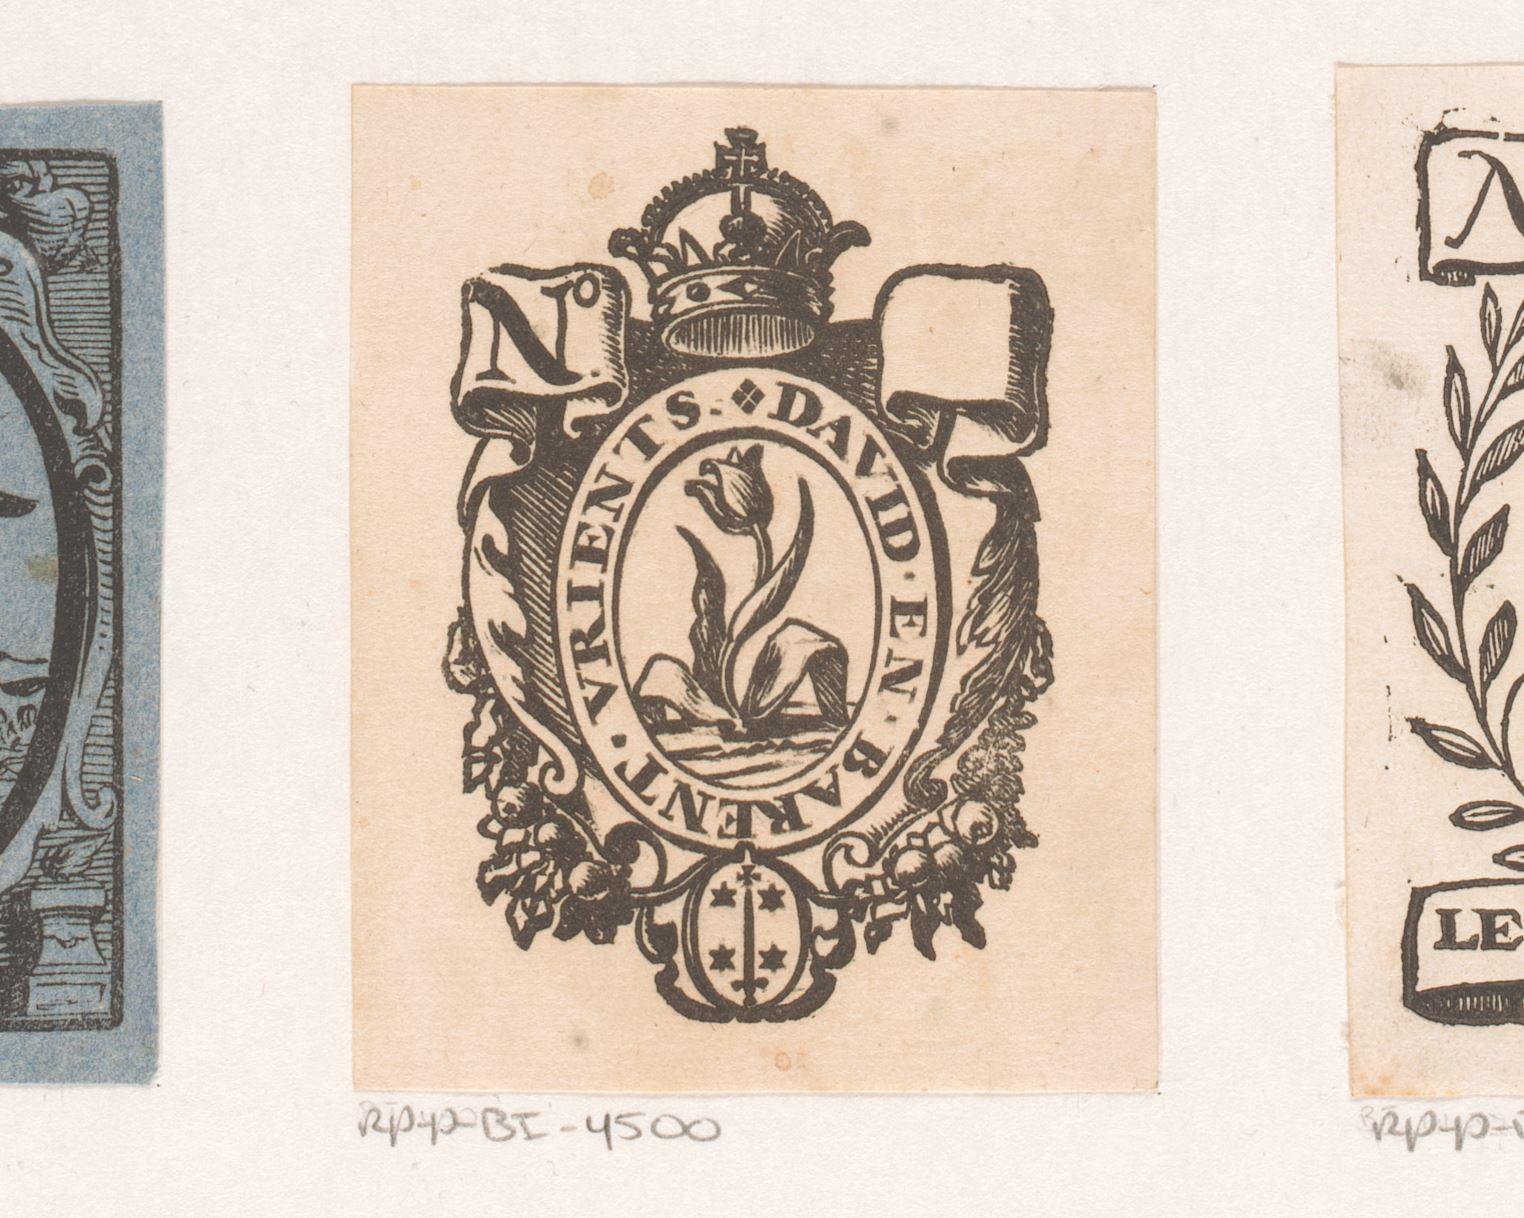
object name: print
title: Vignet van David en Barent Vrients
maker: Anonymous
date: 1600-1699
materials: paper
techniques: woodcut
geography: netherlands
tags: coat of arms (as symbol of the state, etc.) (+ city; municipal), crown (symbol of sovereignty), flowers: tulip, vignette, haarlem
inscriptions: collector's mark: Lugt 240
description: Een tulp in een ovaal met randschrift. Midden boven een kroon. Midden onder het wapen van de stad Haarlem.